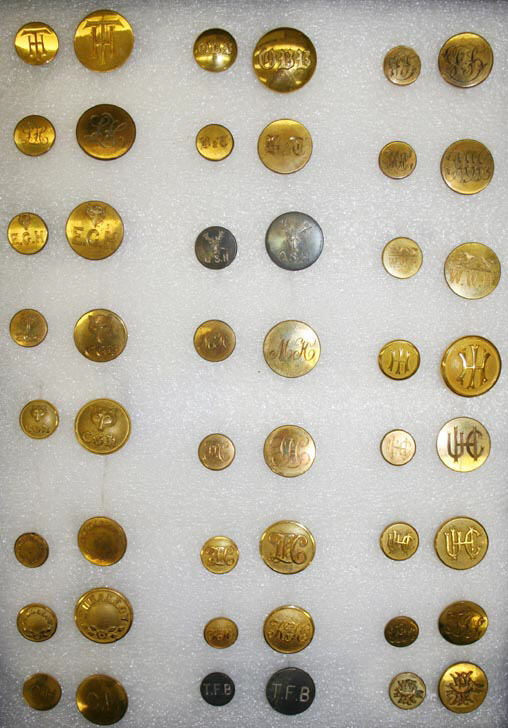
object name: button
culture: british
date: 1850-1880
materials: metal